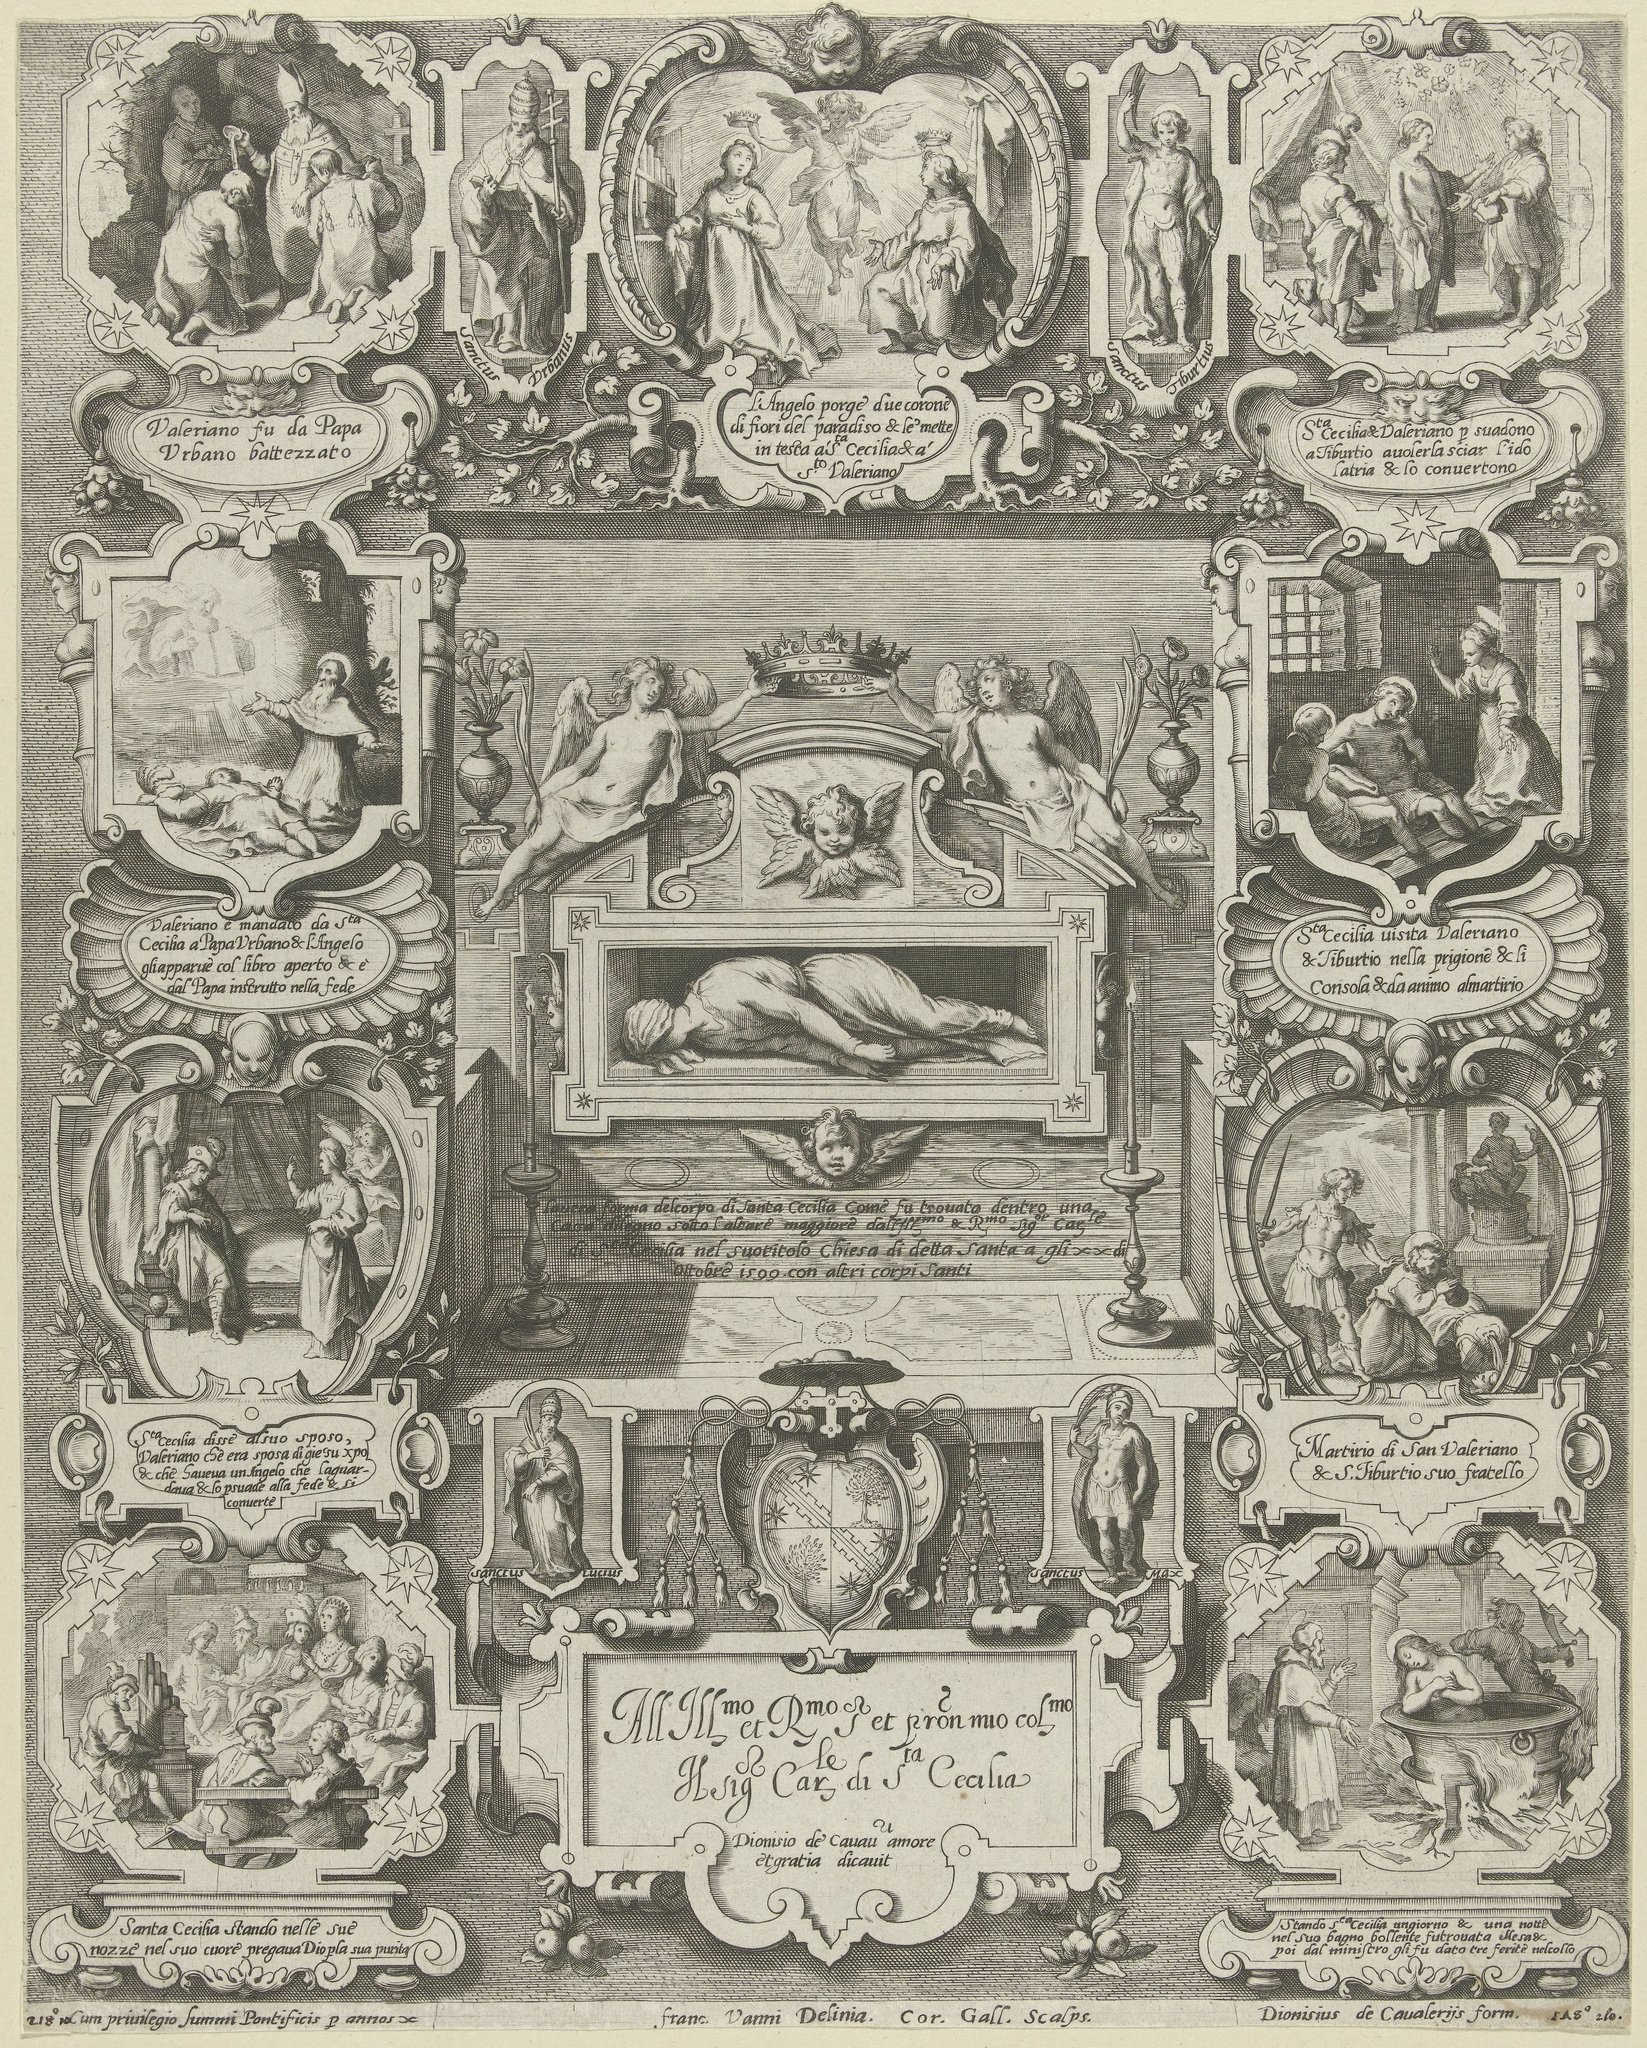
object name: print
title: Graftombe van de H. Cecilia in de Santa Cecilia in Trastevere in Rome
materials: paper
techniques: engraving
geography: italy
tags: grave, tomb, the virgin martyr cecilia of rome; possible attributes: falcon, musical instruments, organ, wreath of roses and lilies - portrait of female saint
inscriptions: collector's mark: Lugt 240, number: ‘218 no. / 1A8 2/o’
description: De graftombe van de H. Cecilia in de Santa Cecilia in Trastevere in Rome. De Heilige ligt in het graf. De graftome in het midden is omgeven door negen cartouches met scènes uit het leven van de H. Cecilia en verklarende tekst.